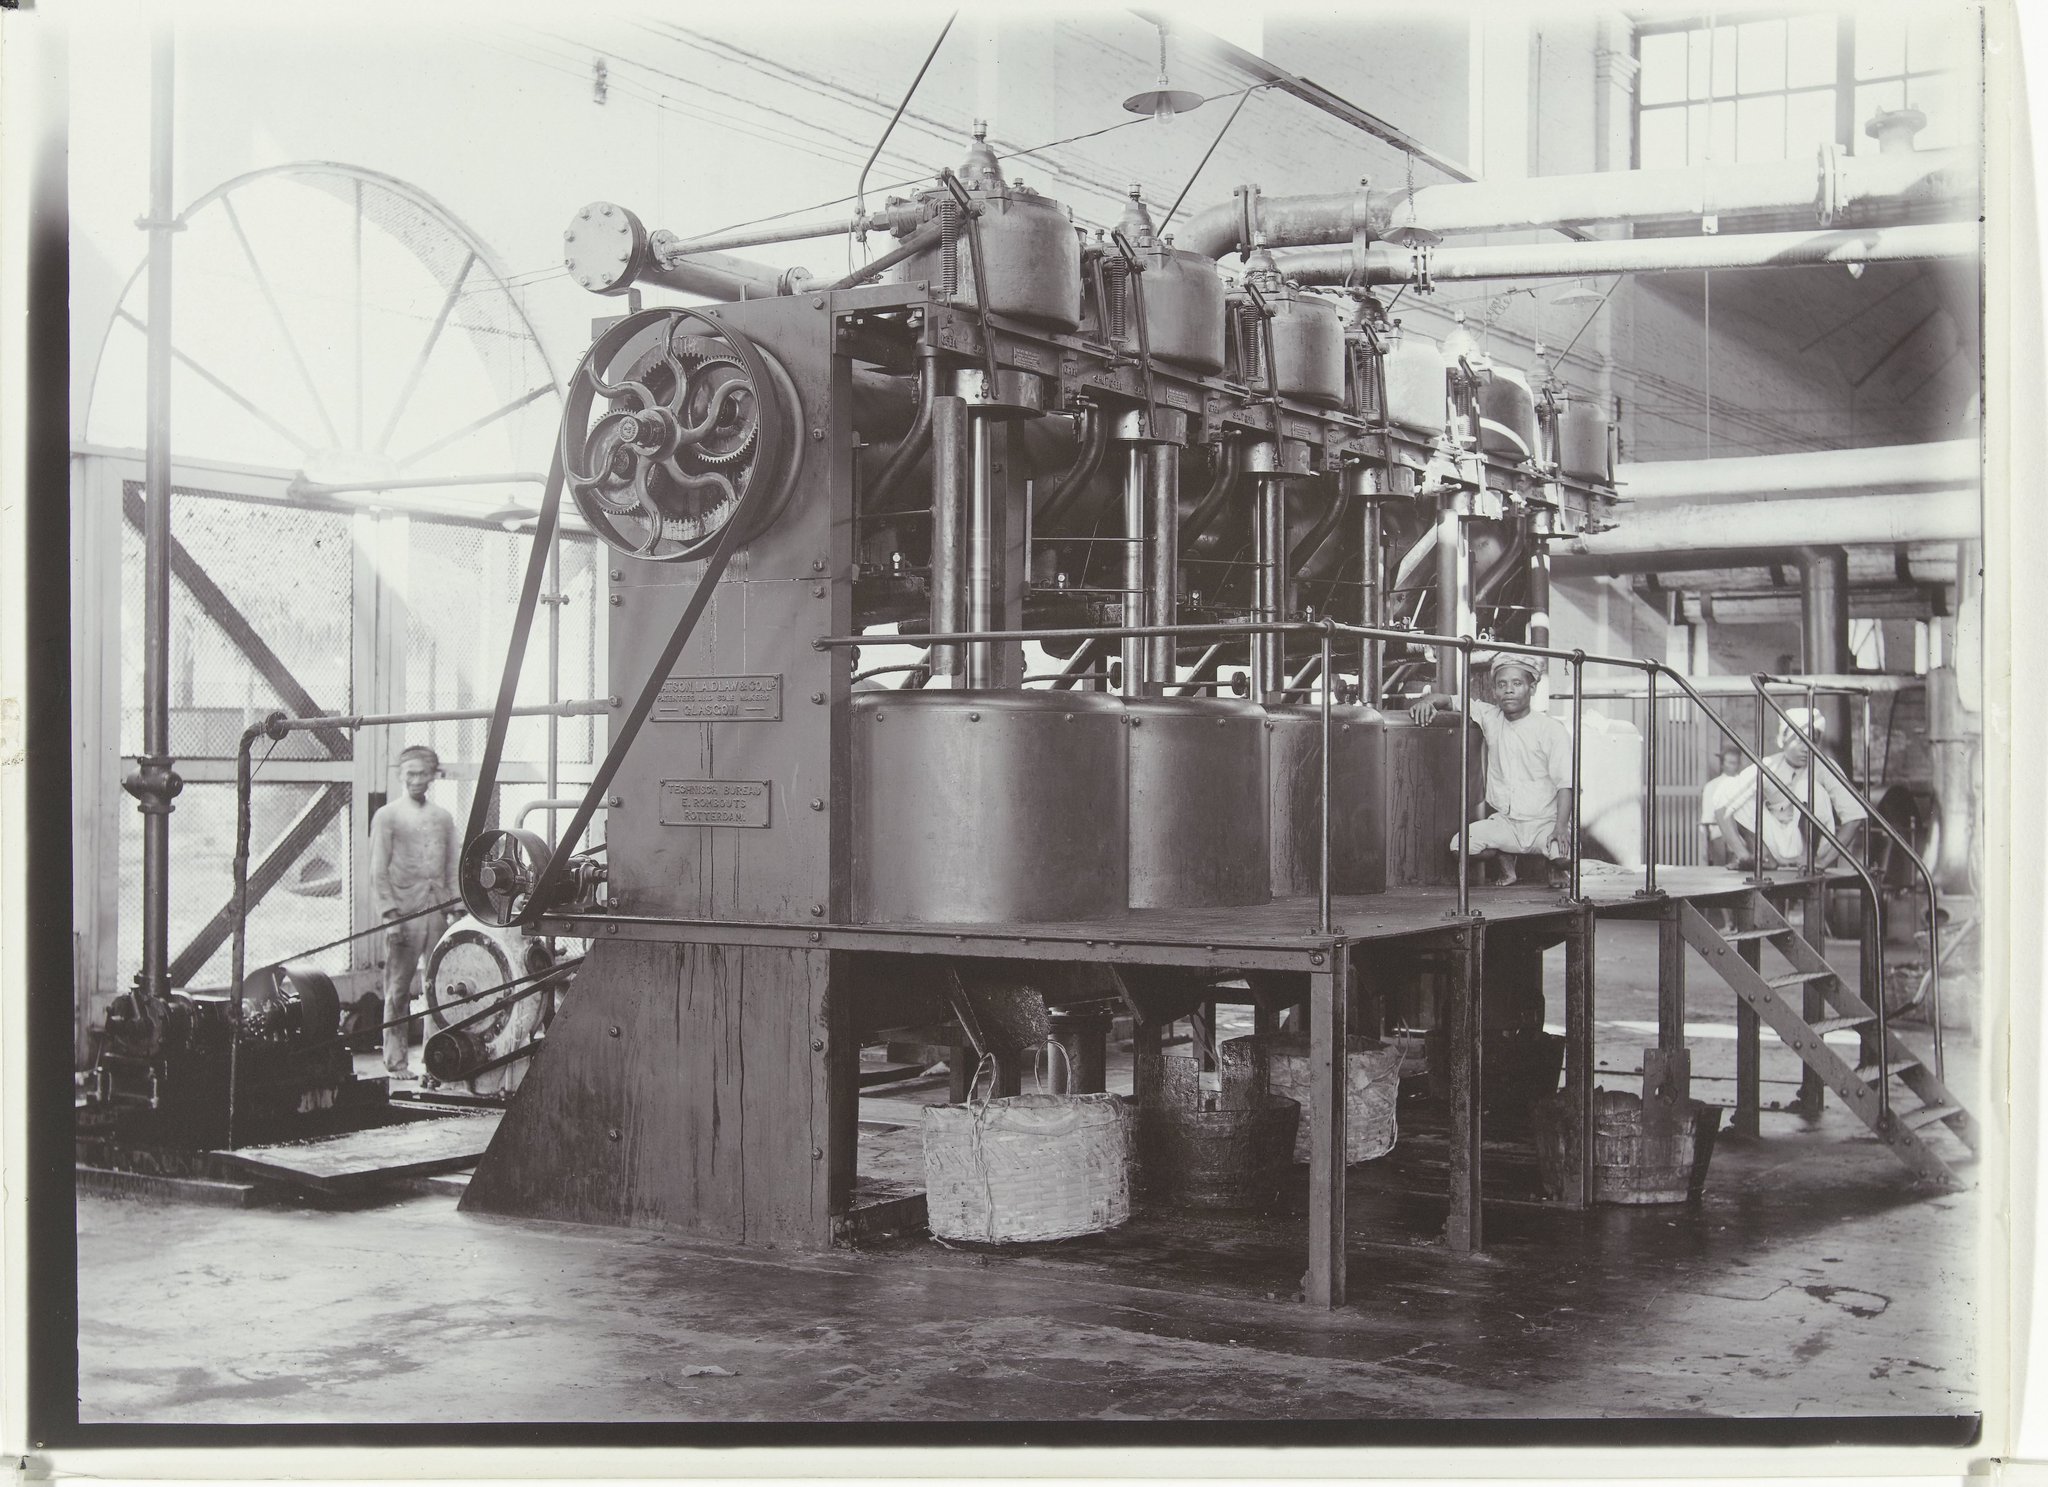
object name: photograph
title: Machine in de fabriek van de suikeronderneming Nieuw Tersana, Cheribon, voormalig Nederlands-Indië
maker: onnes kurkdjian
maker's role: fotograaf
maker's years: 1851-1903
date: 1890-1911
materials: paper, photographic support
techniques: gelatin silver print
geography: dutch east indies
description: Machine voor het verwerken van suikerriet in de fabriek van de suikeronderneming Nieuw Tersana, Cheribon, voormalig Nederlands-Indië